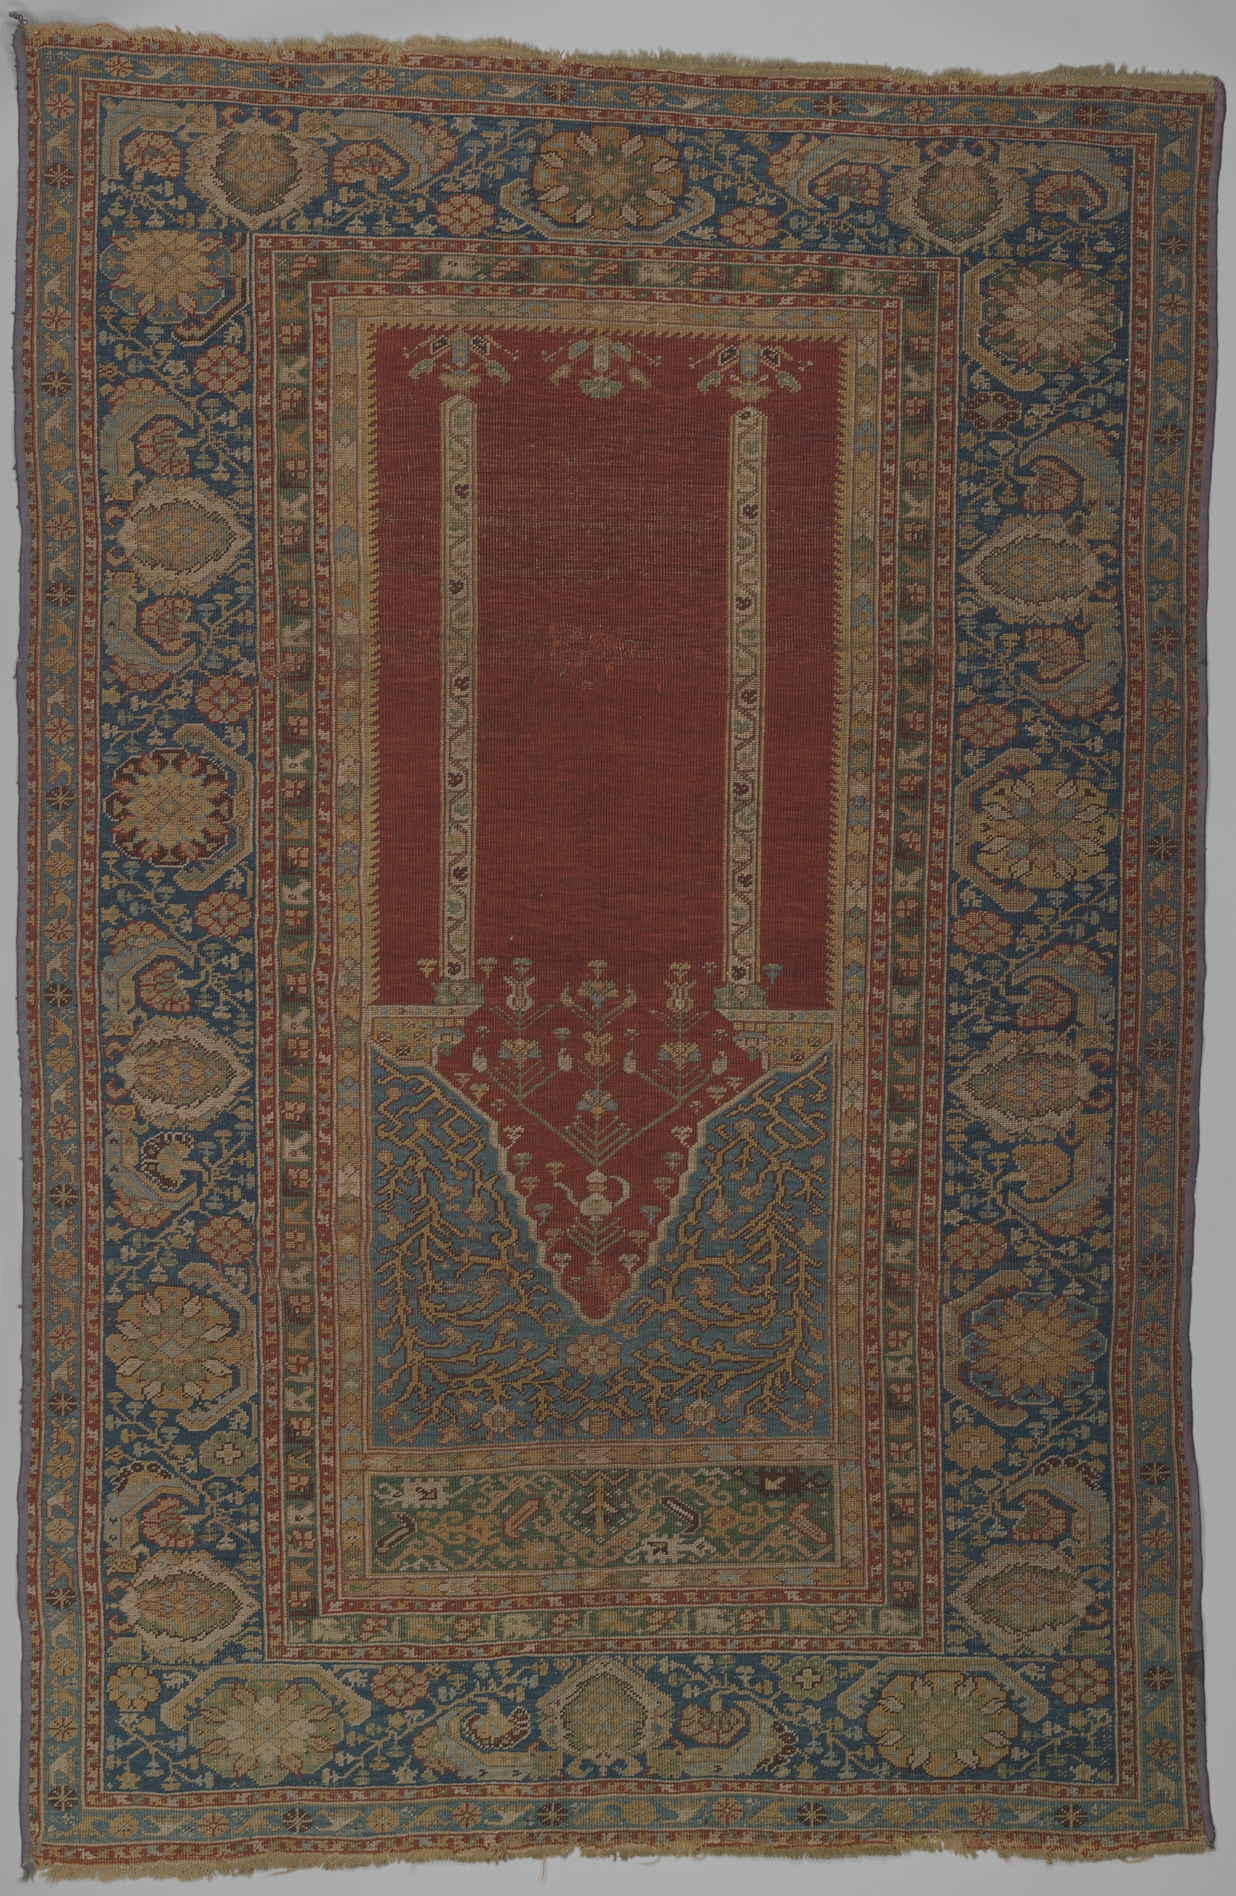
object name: rug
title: Transylvanian prayer rug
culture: turkish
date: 1701-1733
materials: wool